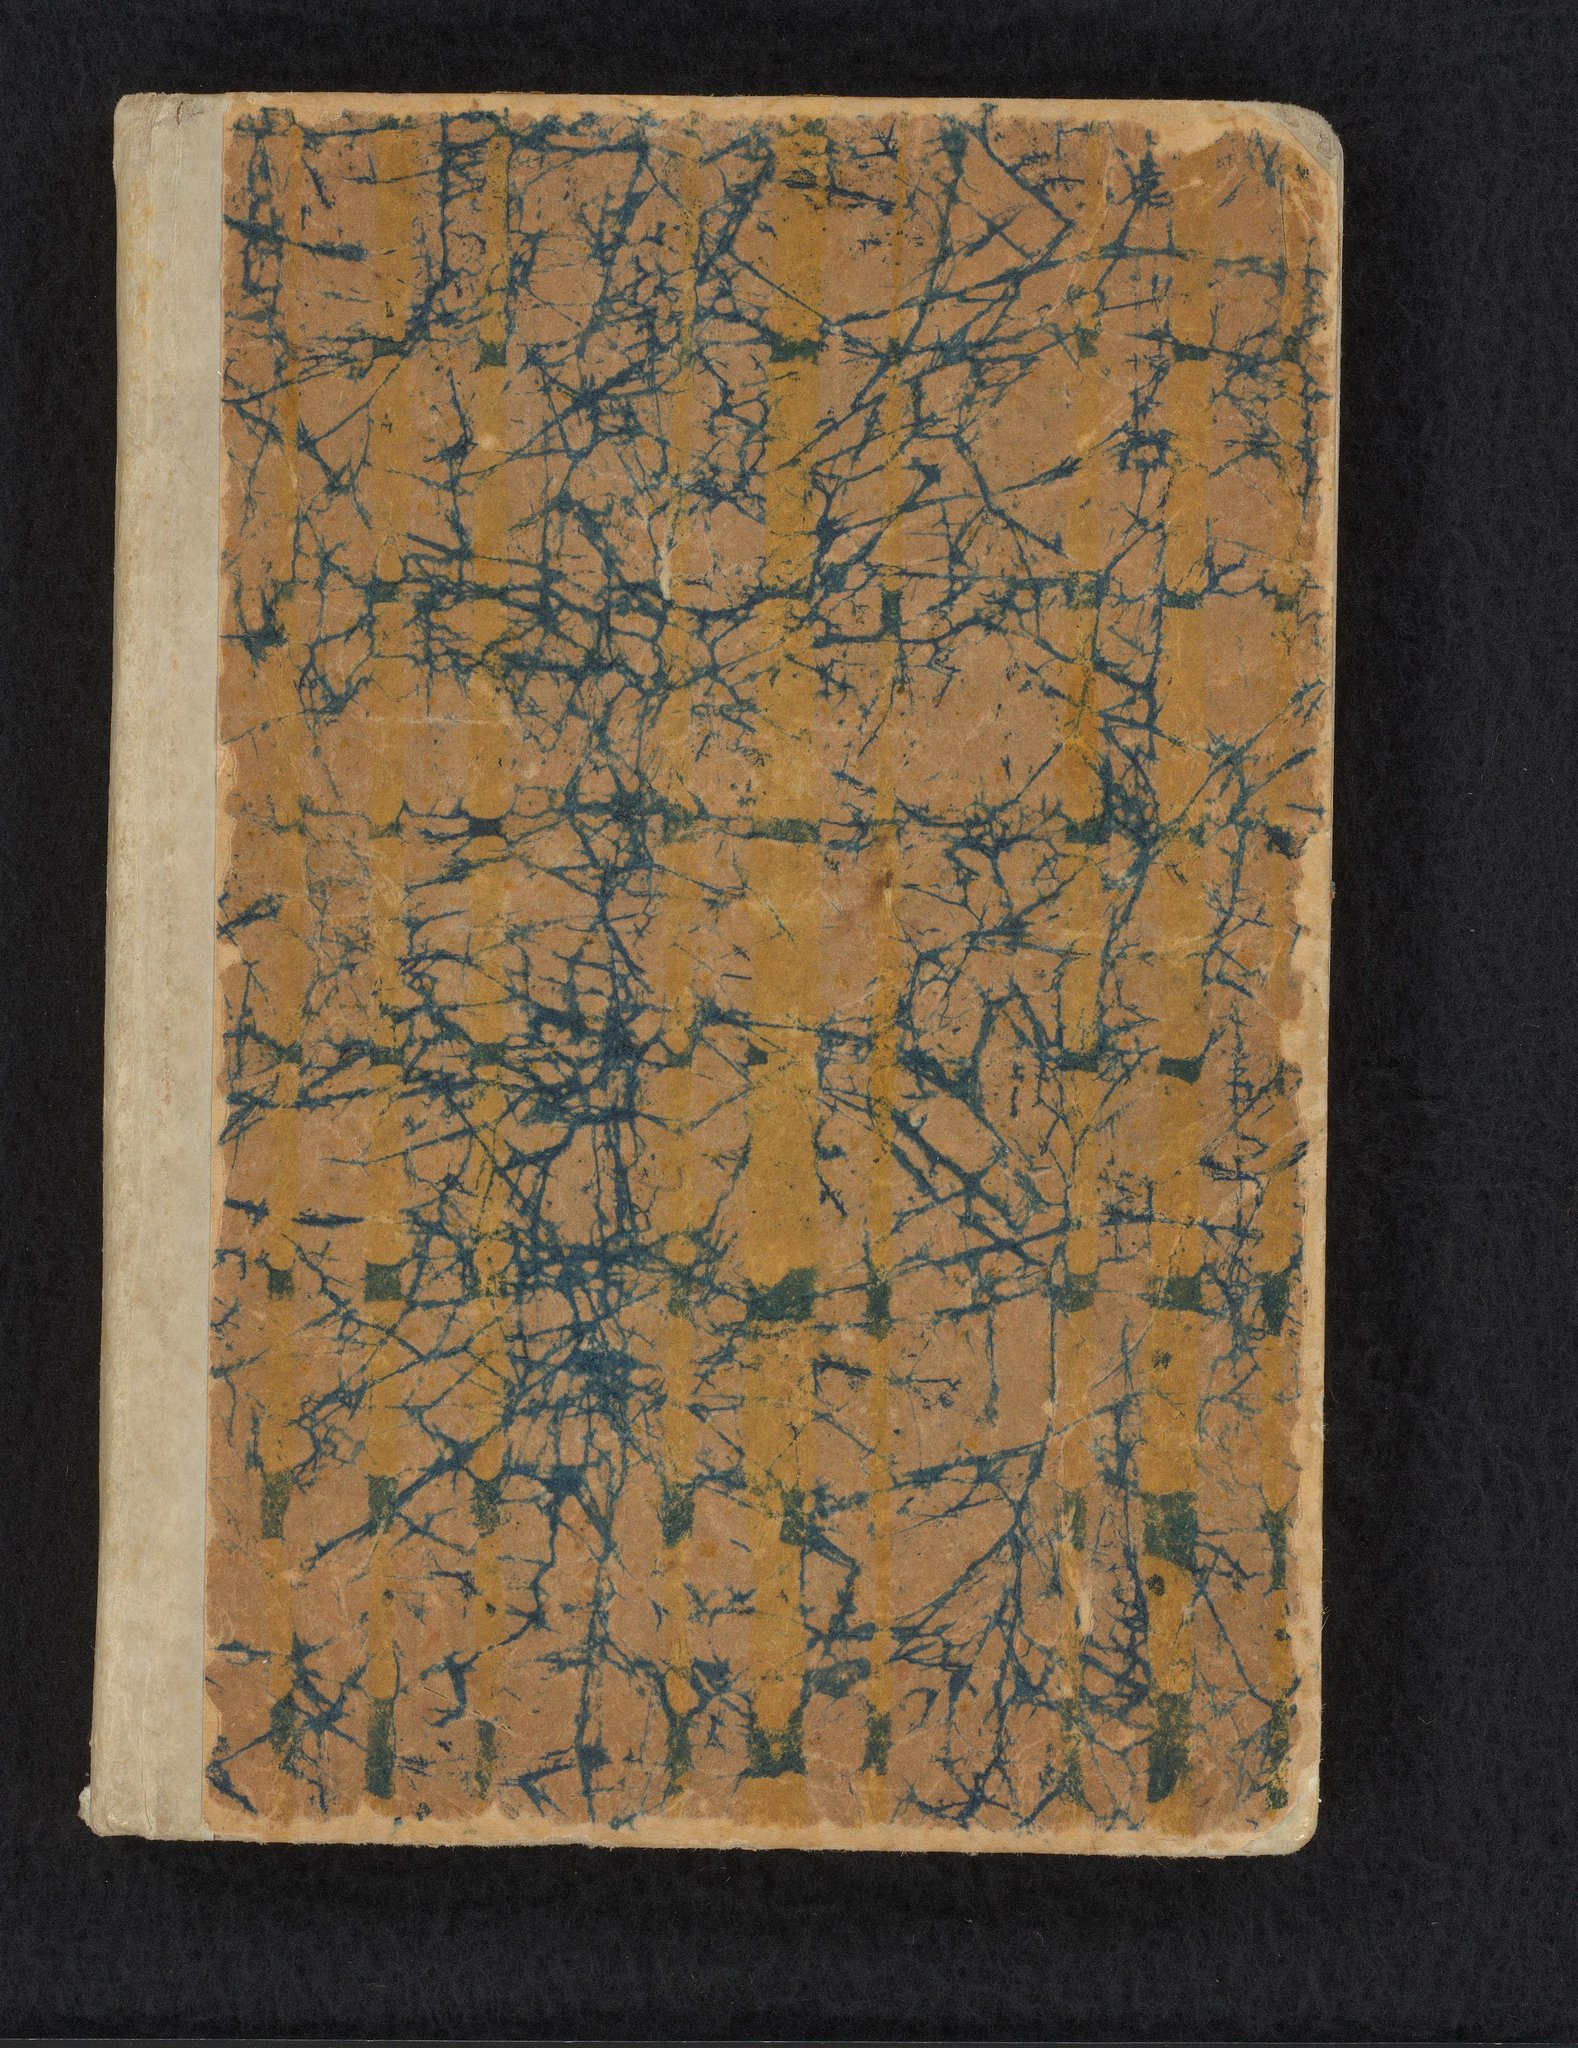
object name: decorated paper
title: Notitieboek met handgeschreven gedichten door Else en Isabel Wachenheimer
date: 1920-1964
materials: cardboard, ink, paper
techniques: handwriting, pen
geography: germany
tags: else wachenheimer-moos, isabel wachenheimer-elon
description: Dit object is onderdeel van de nalatenschap van Isabel Elon-Wachenheimer (1928-2010). Tot haar overlijden behoorde het samen met de andere objecten uit de nalatenschap tot haar privédomein van Isabel Wachenheimer. In die particuliere context zijn deze objecten tezamen en individueel aandenkens - aan de jeugd, ouders en familie van Isabel Wachenheimer vóór en tijdens de Shoah en aan haar leven na de Tweede Wereldoorlog. Isabel Wachenheimer, die van juni 1943 tot mei 1945 gevangen zat in Kamp Westerbork, Theresienstadt, Auschwitz, Lenzing a/d Oberdonau (een buitenkamp van Mauthausen), overleefde de Shoah. Haar ouders – Eugène Wachenheimer en Else Wachenheimer-Moos - werden op 14 oktober 1944 in Auschwitz-Birkenau vermoord.